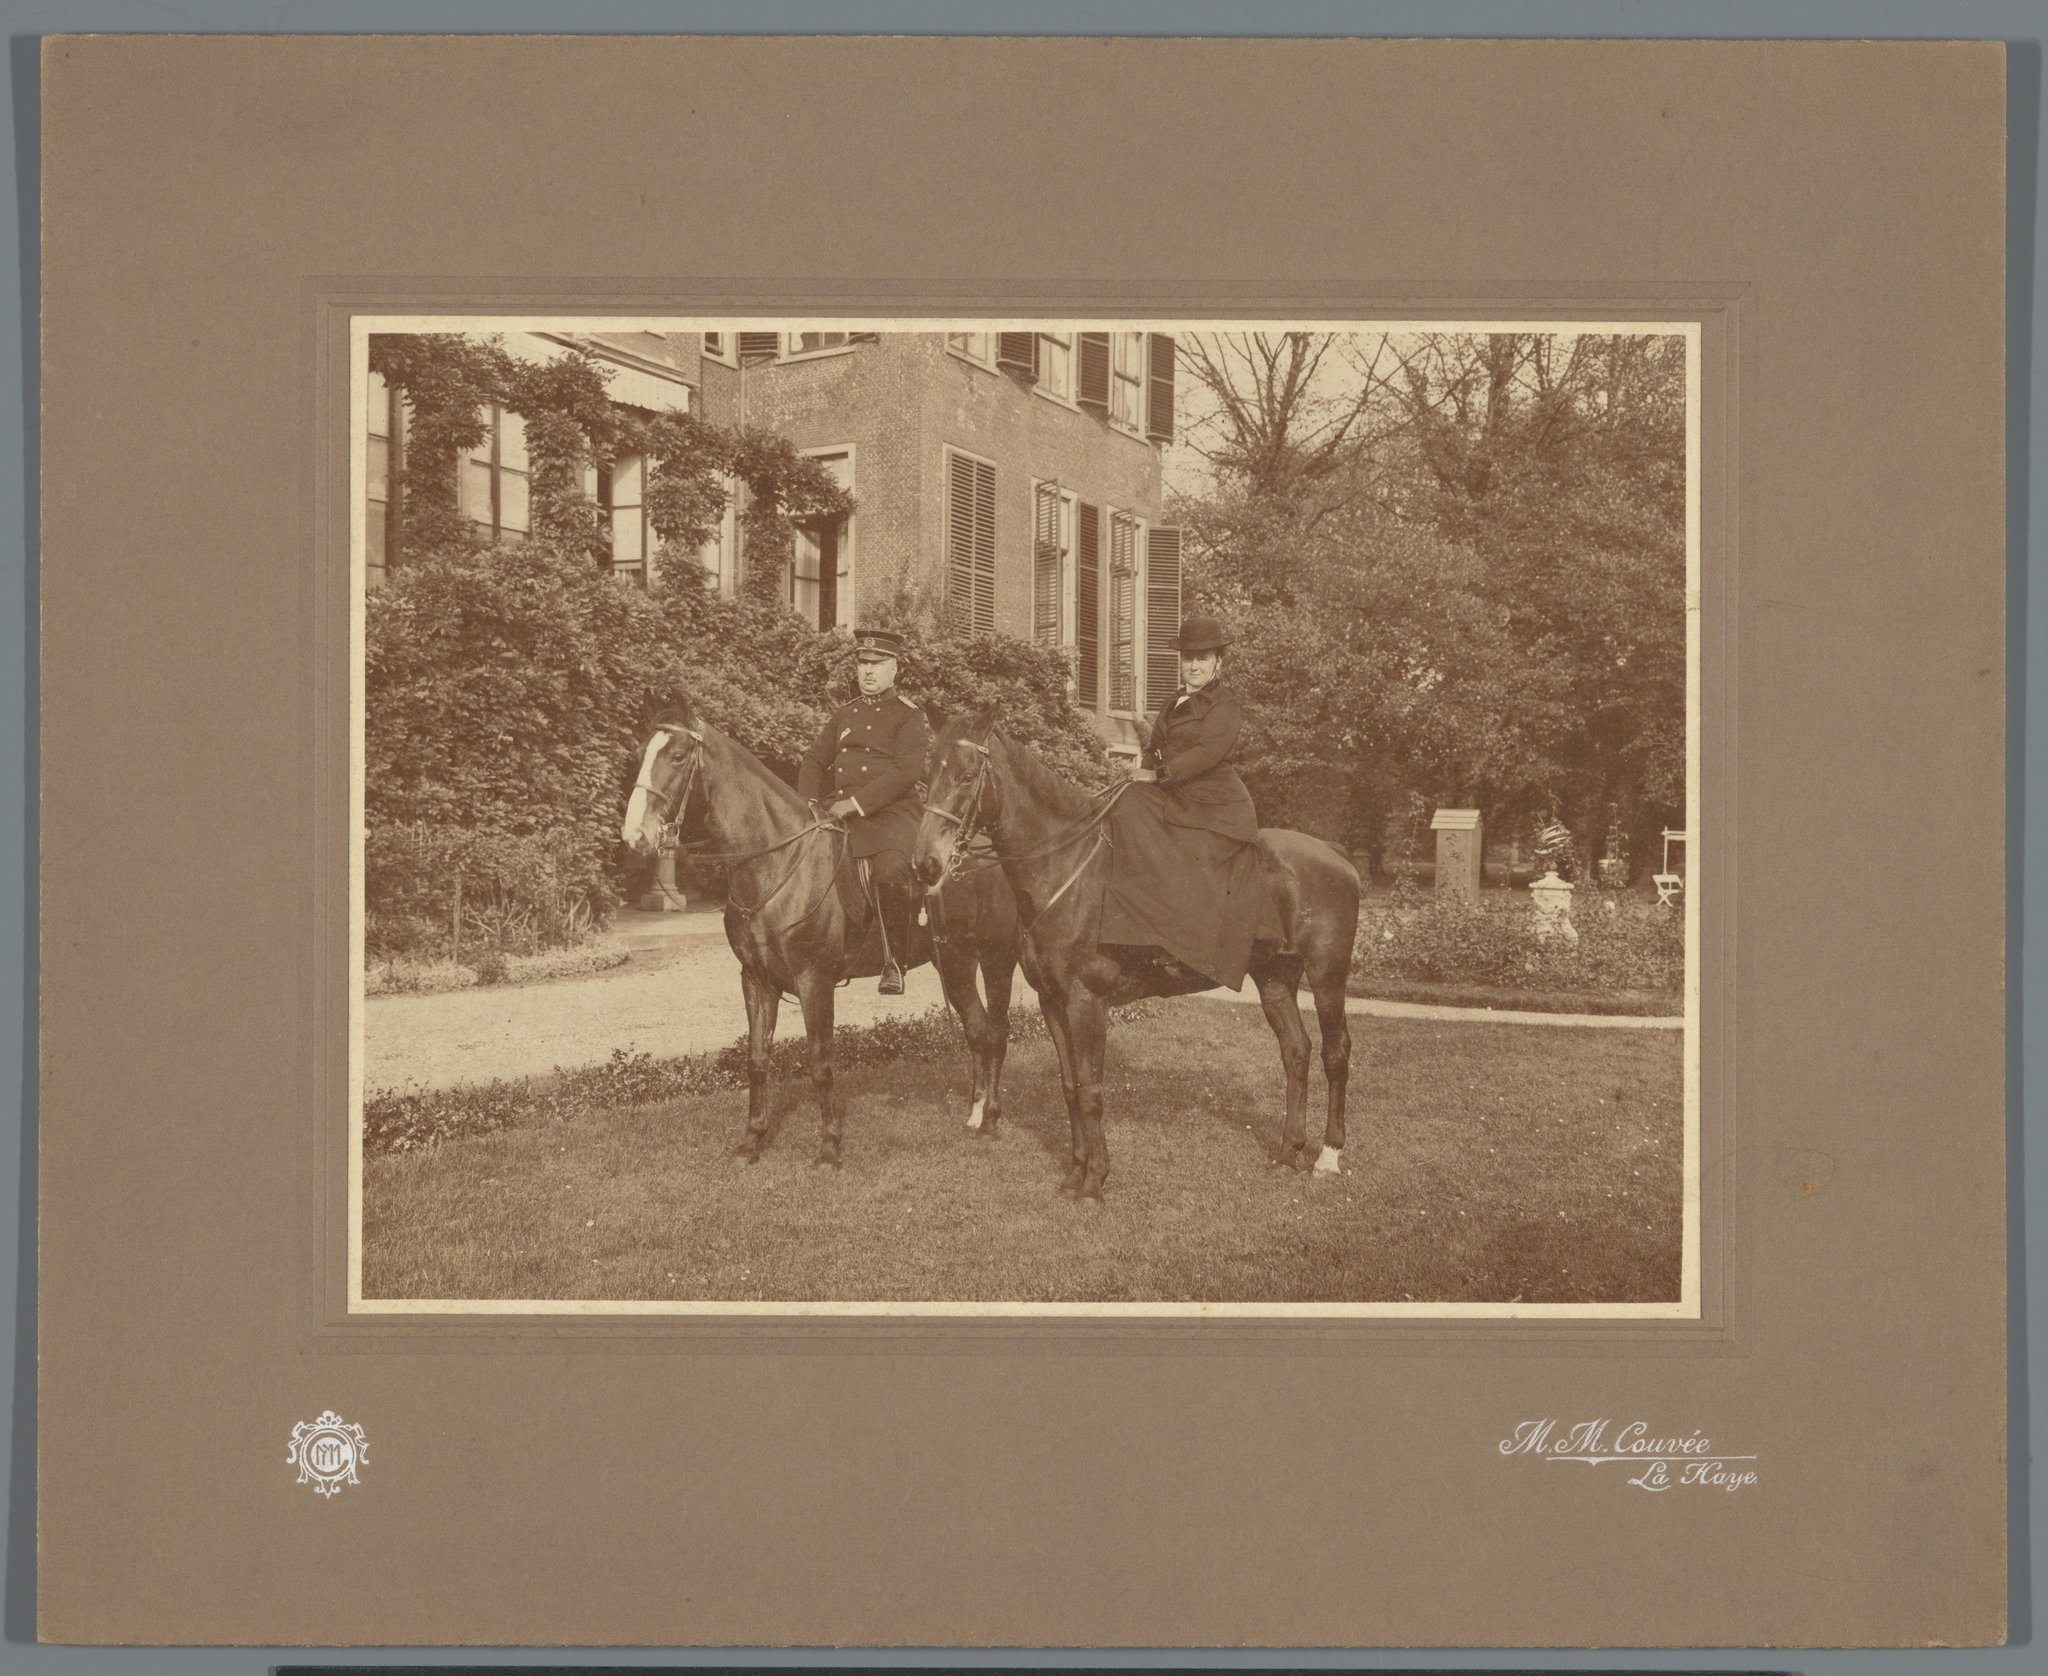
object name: photograph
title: Koningin Wilhelmina en prins Hendrik te paard in park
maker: m.m. couvée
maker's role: publisher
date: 1915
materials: cardboard, photographic support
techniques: albumen print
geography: the hague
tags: the hague, print maker, wilhelmina of the netherlands, hendrik (prins der nederlanden (1876-1934))